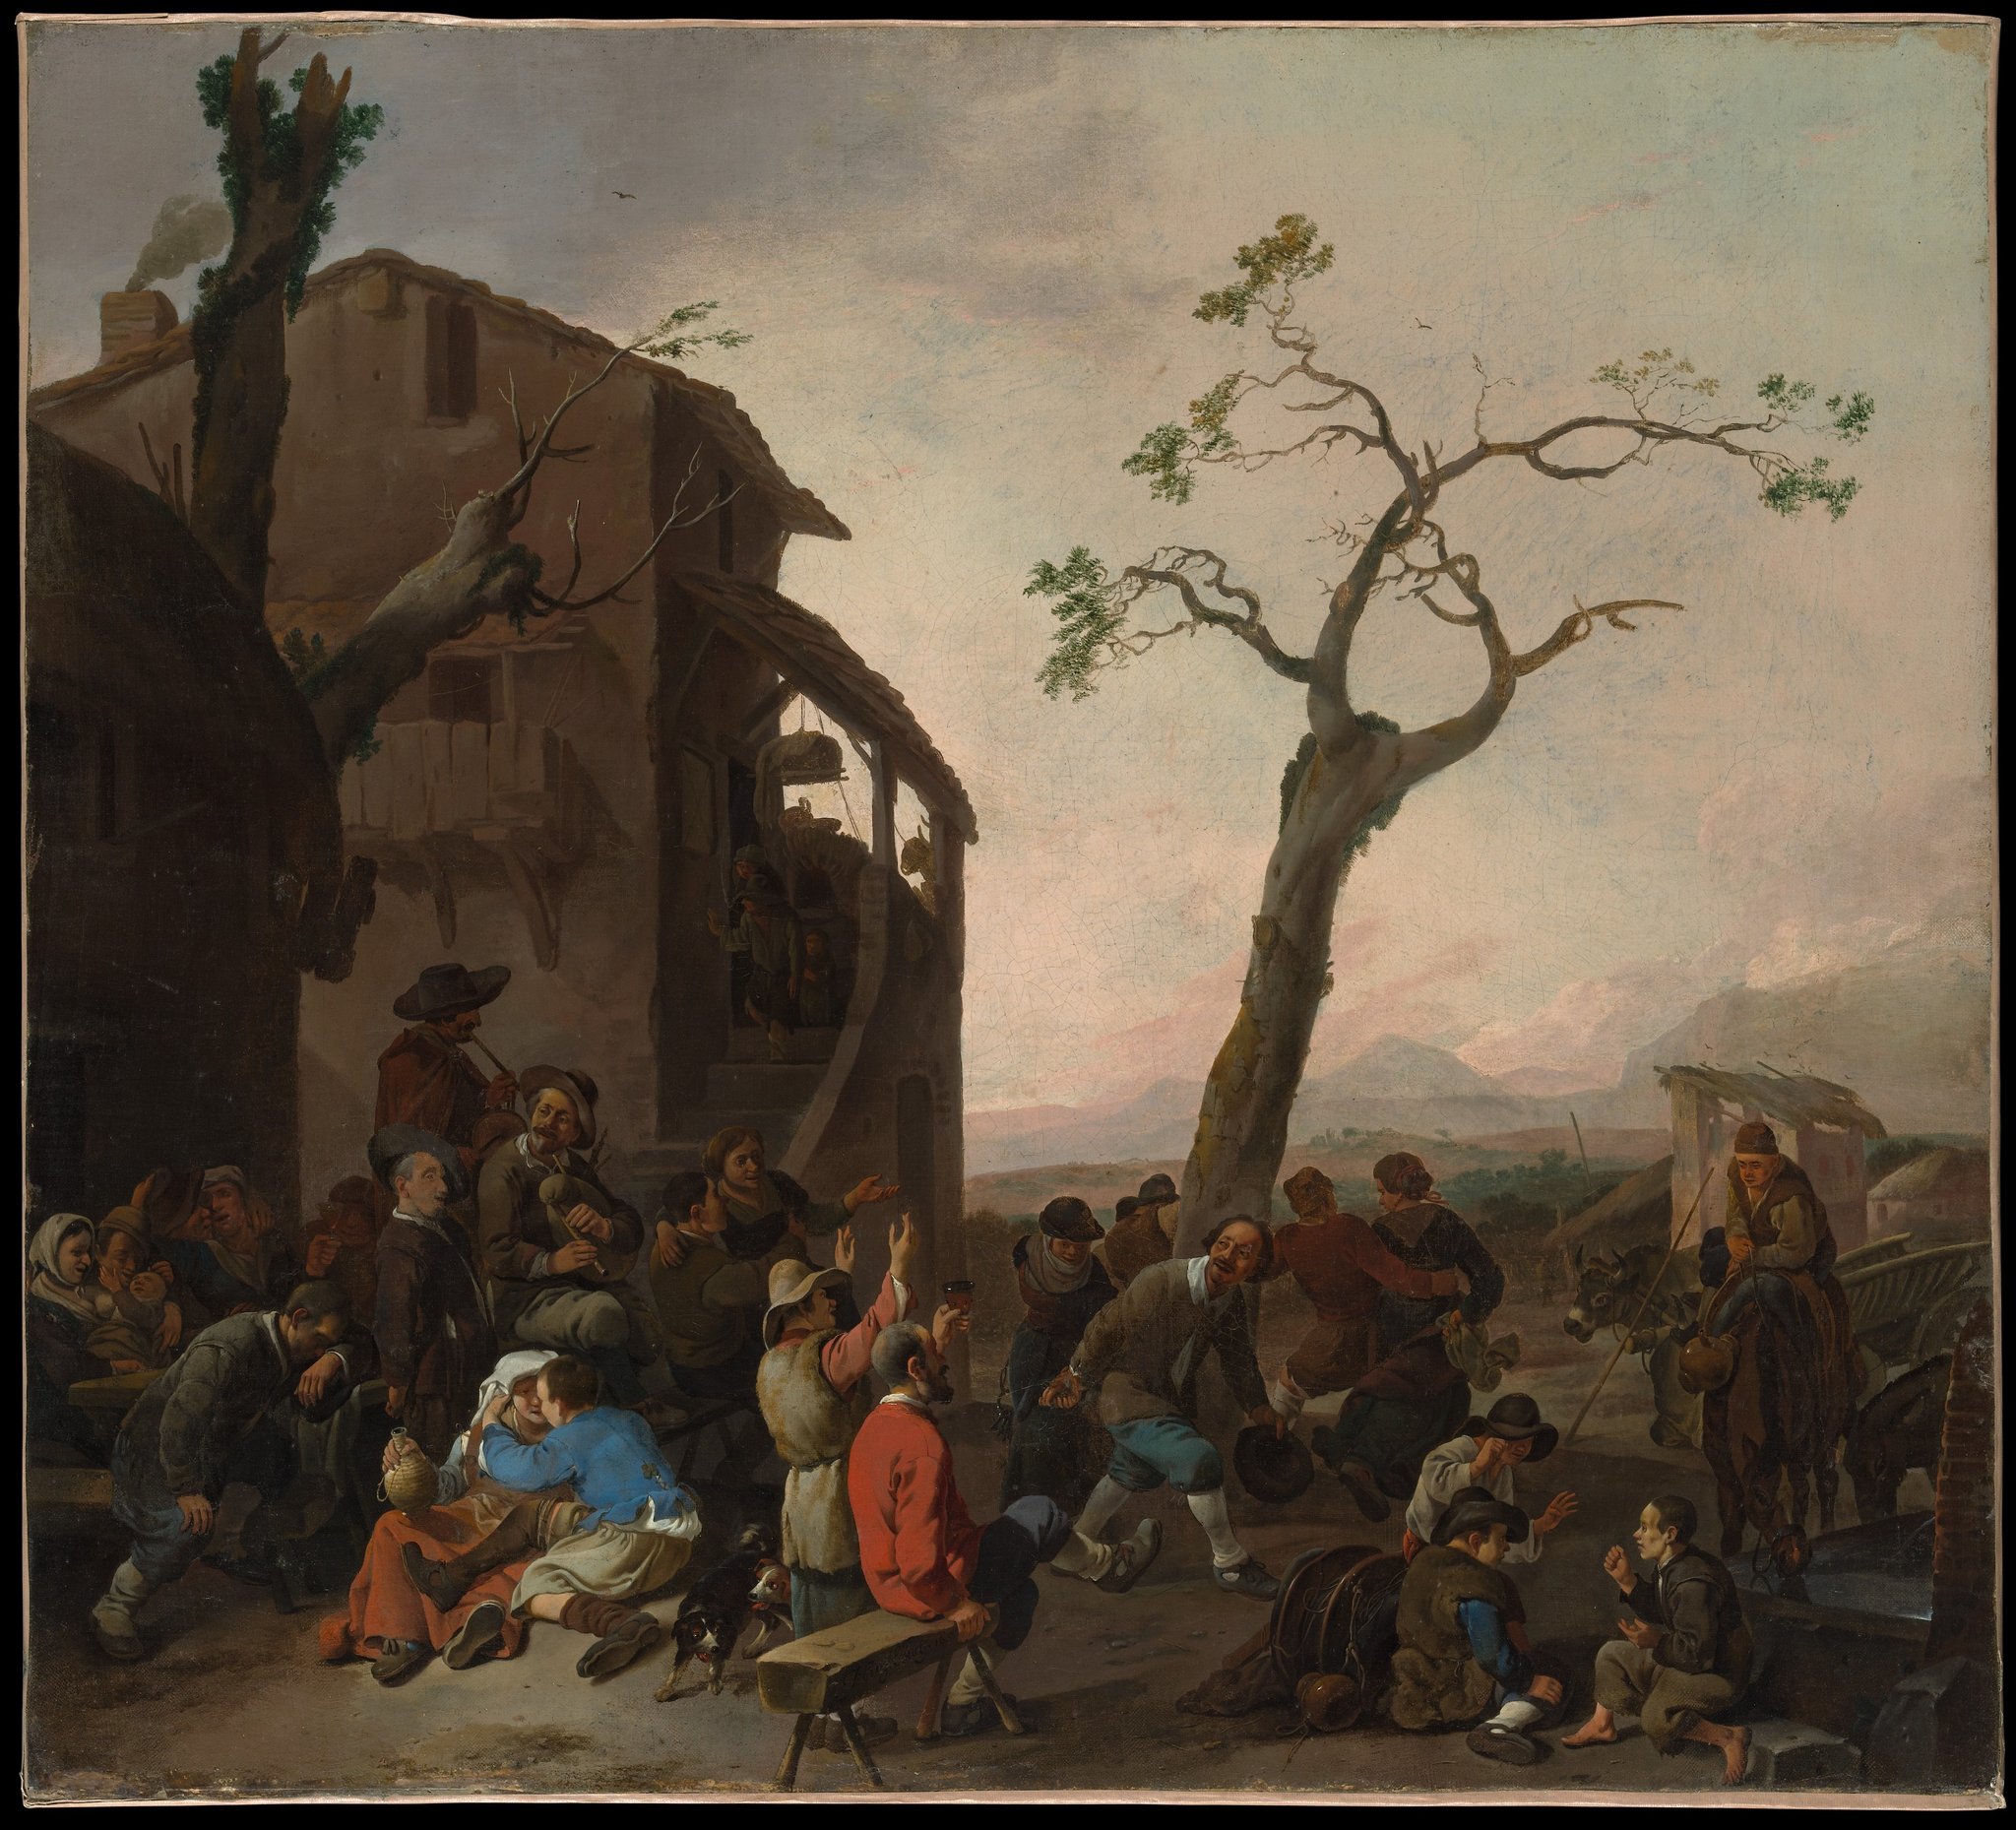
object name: painting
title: Peasants Dancing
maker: johannes lingelbach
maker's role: artist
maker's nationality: dutch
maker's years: 1622-1674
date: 1651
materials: canvas, oil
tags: men,women,dancing,dogs